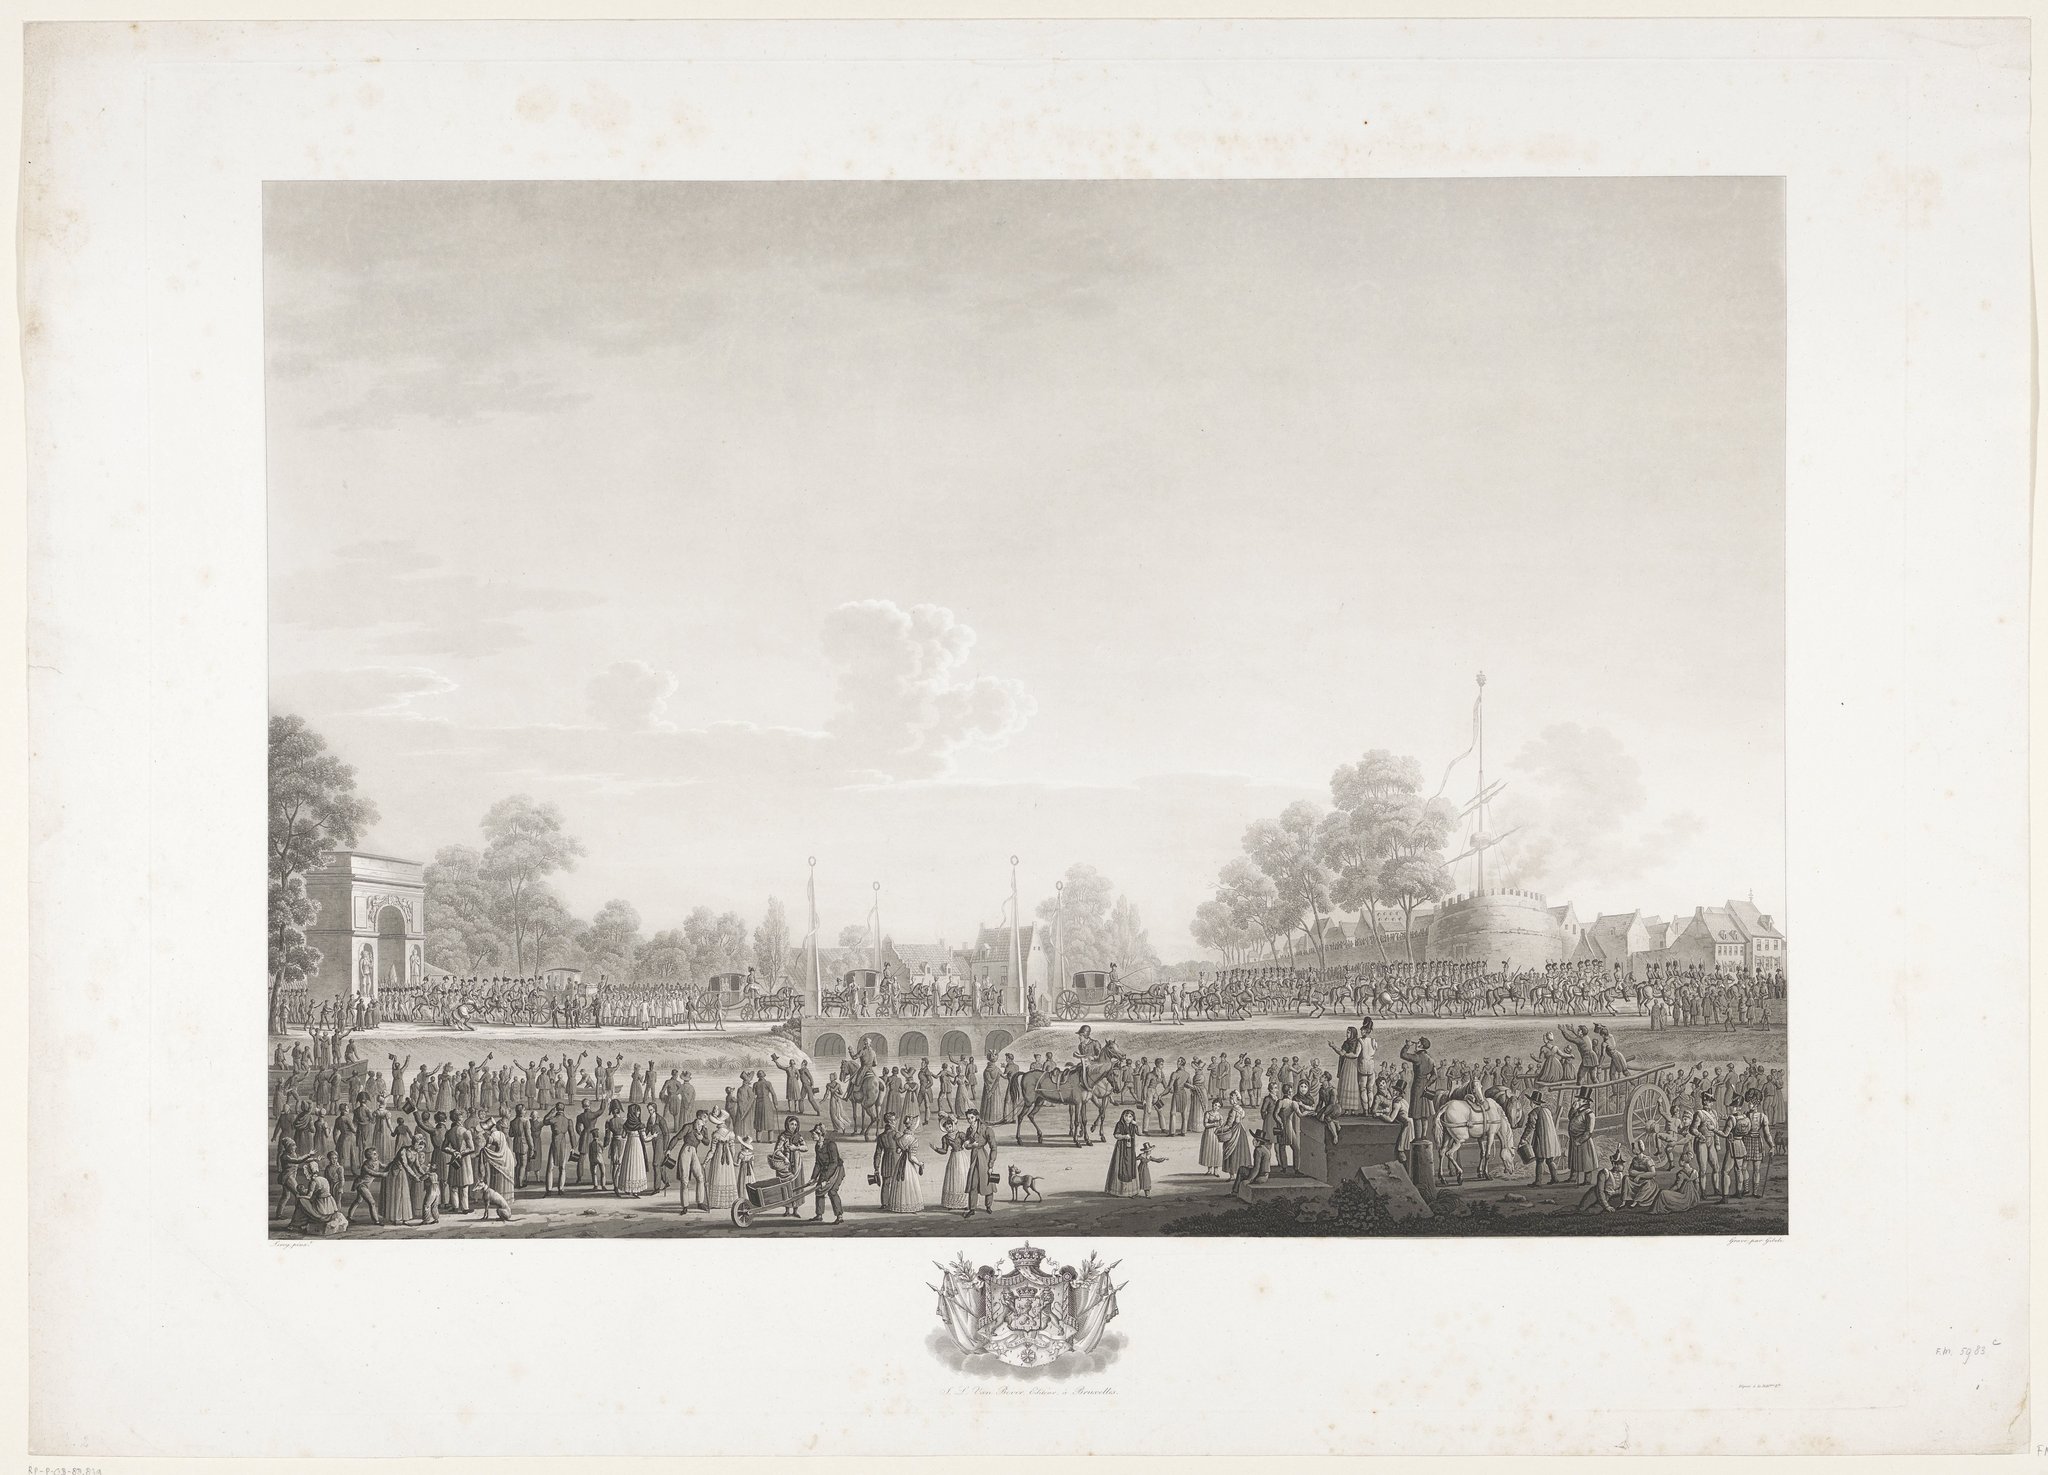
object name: history print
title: Twaalf platen van de aankomst en inhuldiging van Willem I in Brussel en de slagen bij Quatre-Bras en Waterloo in 1815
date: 1825-1826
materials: paper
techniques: aquatint, etching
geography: brussels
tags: berlin, william i of the netherlands, triumphal entry and public reception, pageant, 'entrée solennelle', 'joyeuse entrée', brussels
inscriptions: collector's mark: Lugt 2228, : ‘Déposé à la Bib.que R.le’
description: Aankomst van koning Willem I te Brussel op 30 maart 1815. De stoet van rijtuigen begeleid door cavalerie trekt door een poort de stad in. Onderaan het wapen van koning Willem I. Onderdeel van een serie platen van de aankomst en inhuldiging van Willem I in Brussel.